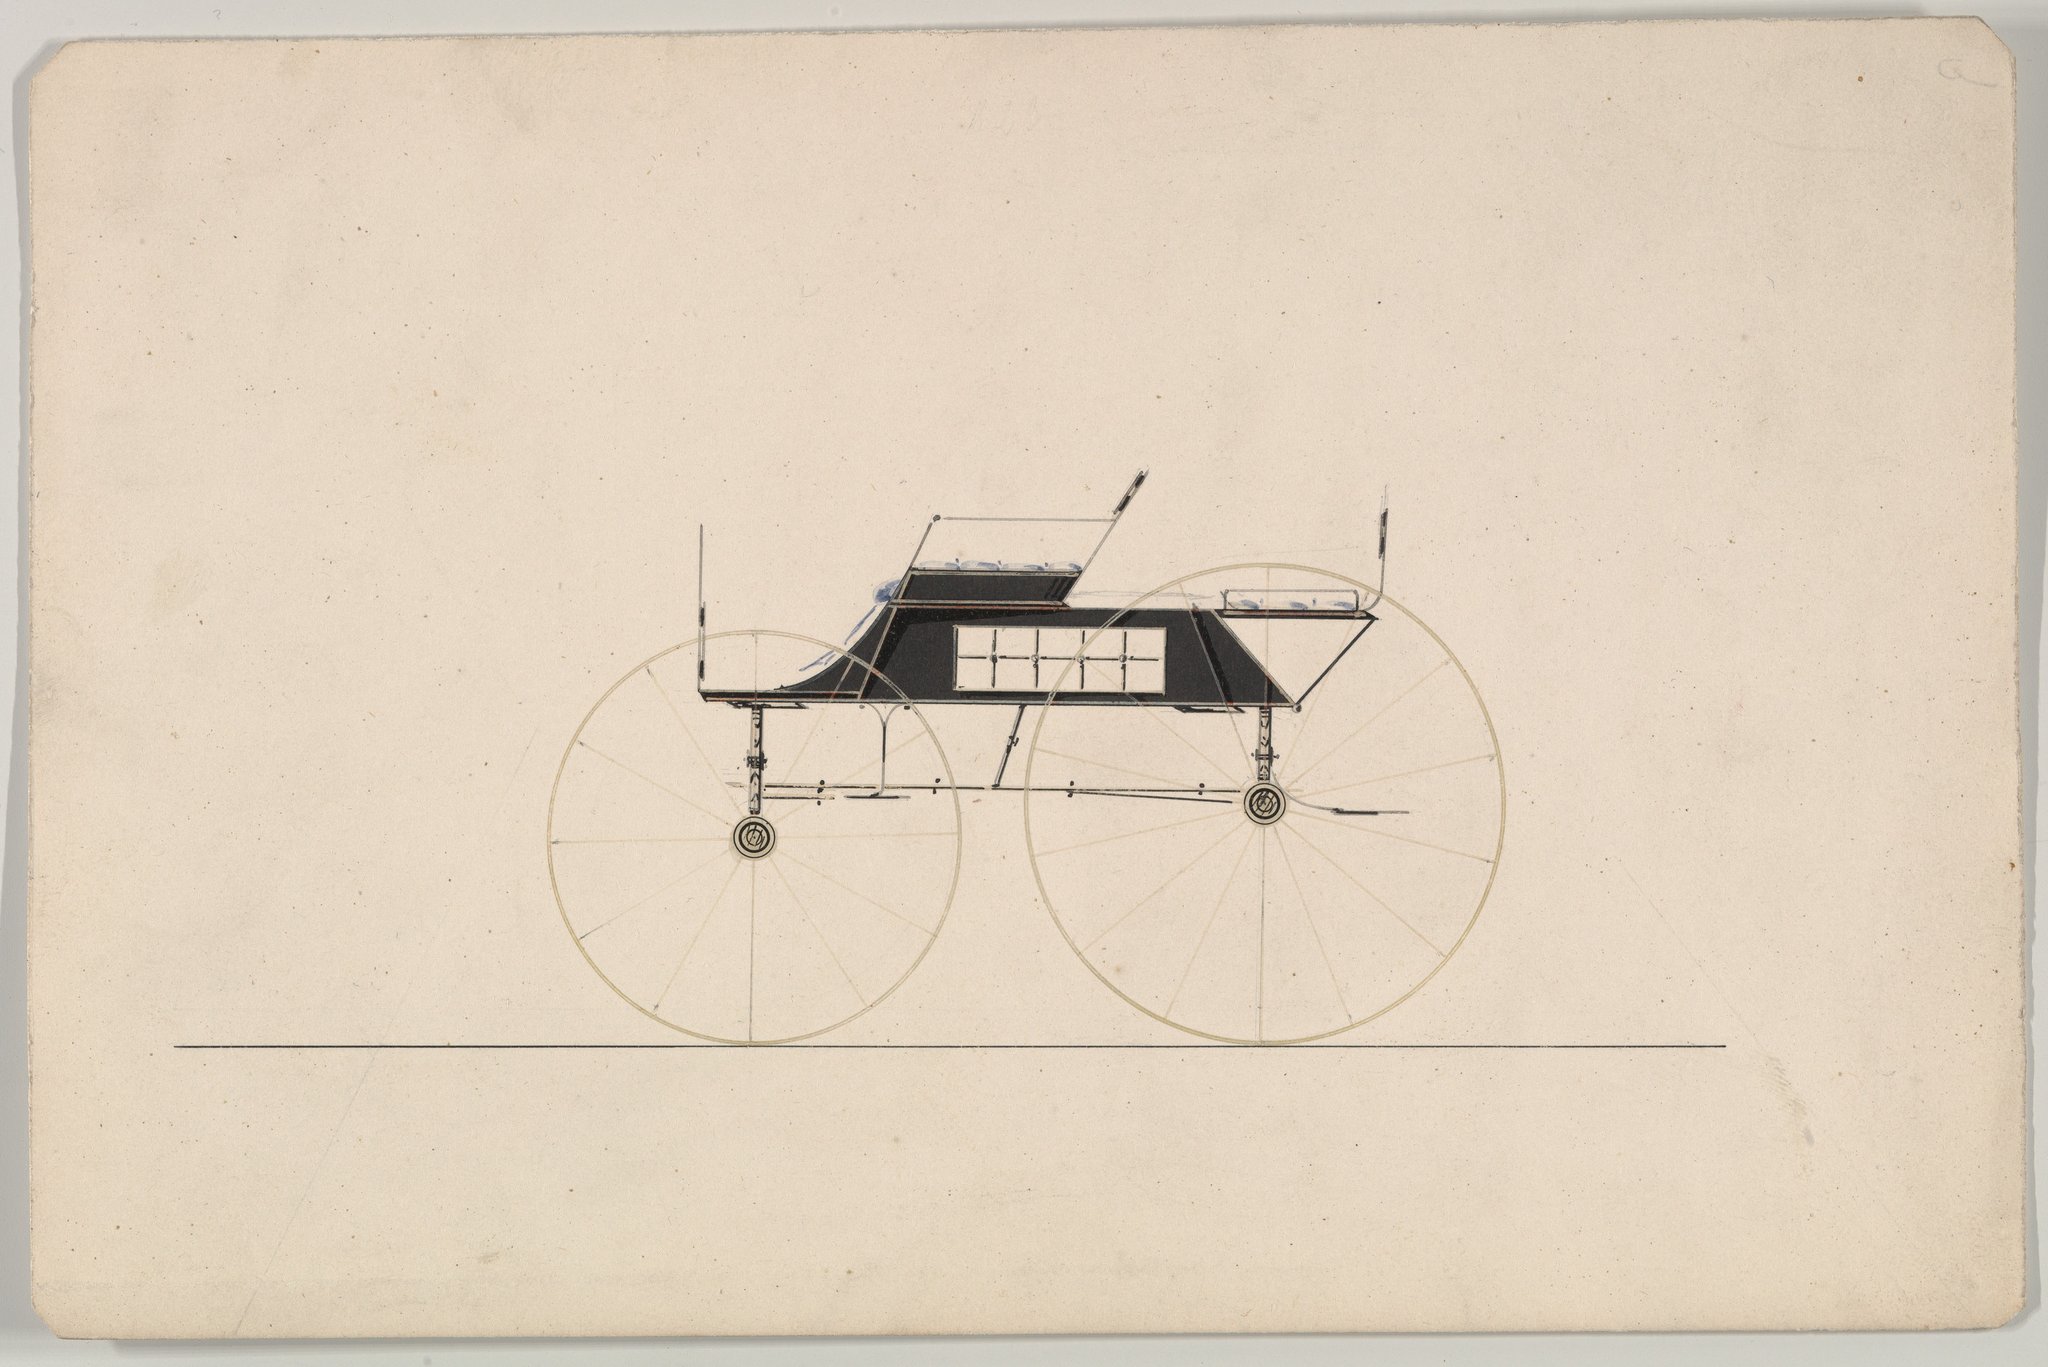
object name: drawing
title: Design for Trap/Shifting Seat Game Wagon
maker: brewster & co.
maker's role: manufacturer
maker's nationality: american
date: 1850-1870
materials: gouache, gum arabic, ink, watercolor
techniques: pen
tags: carriages